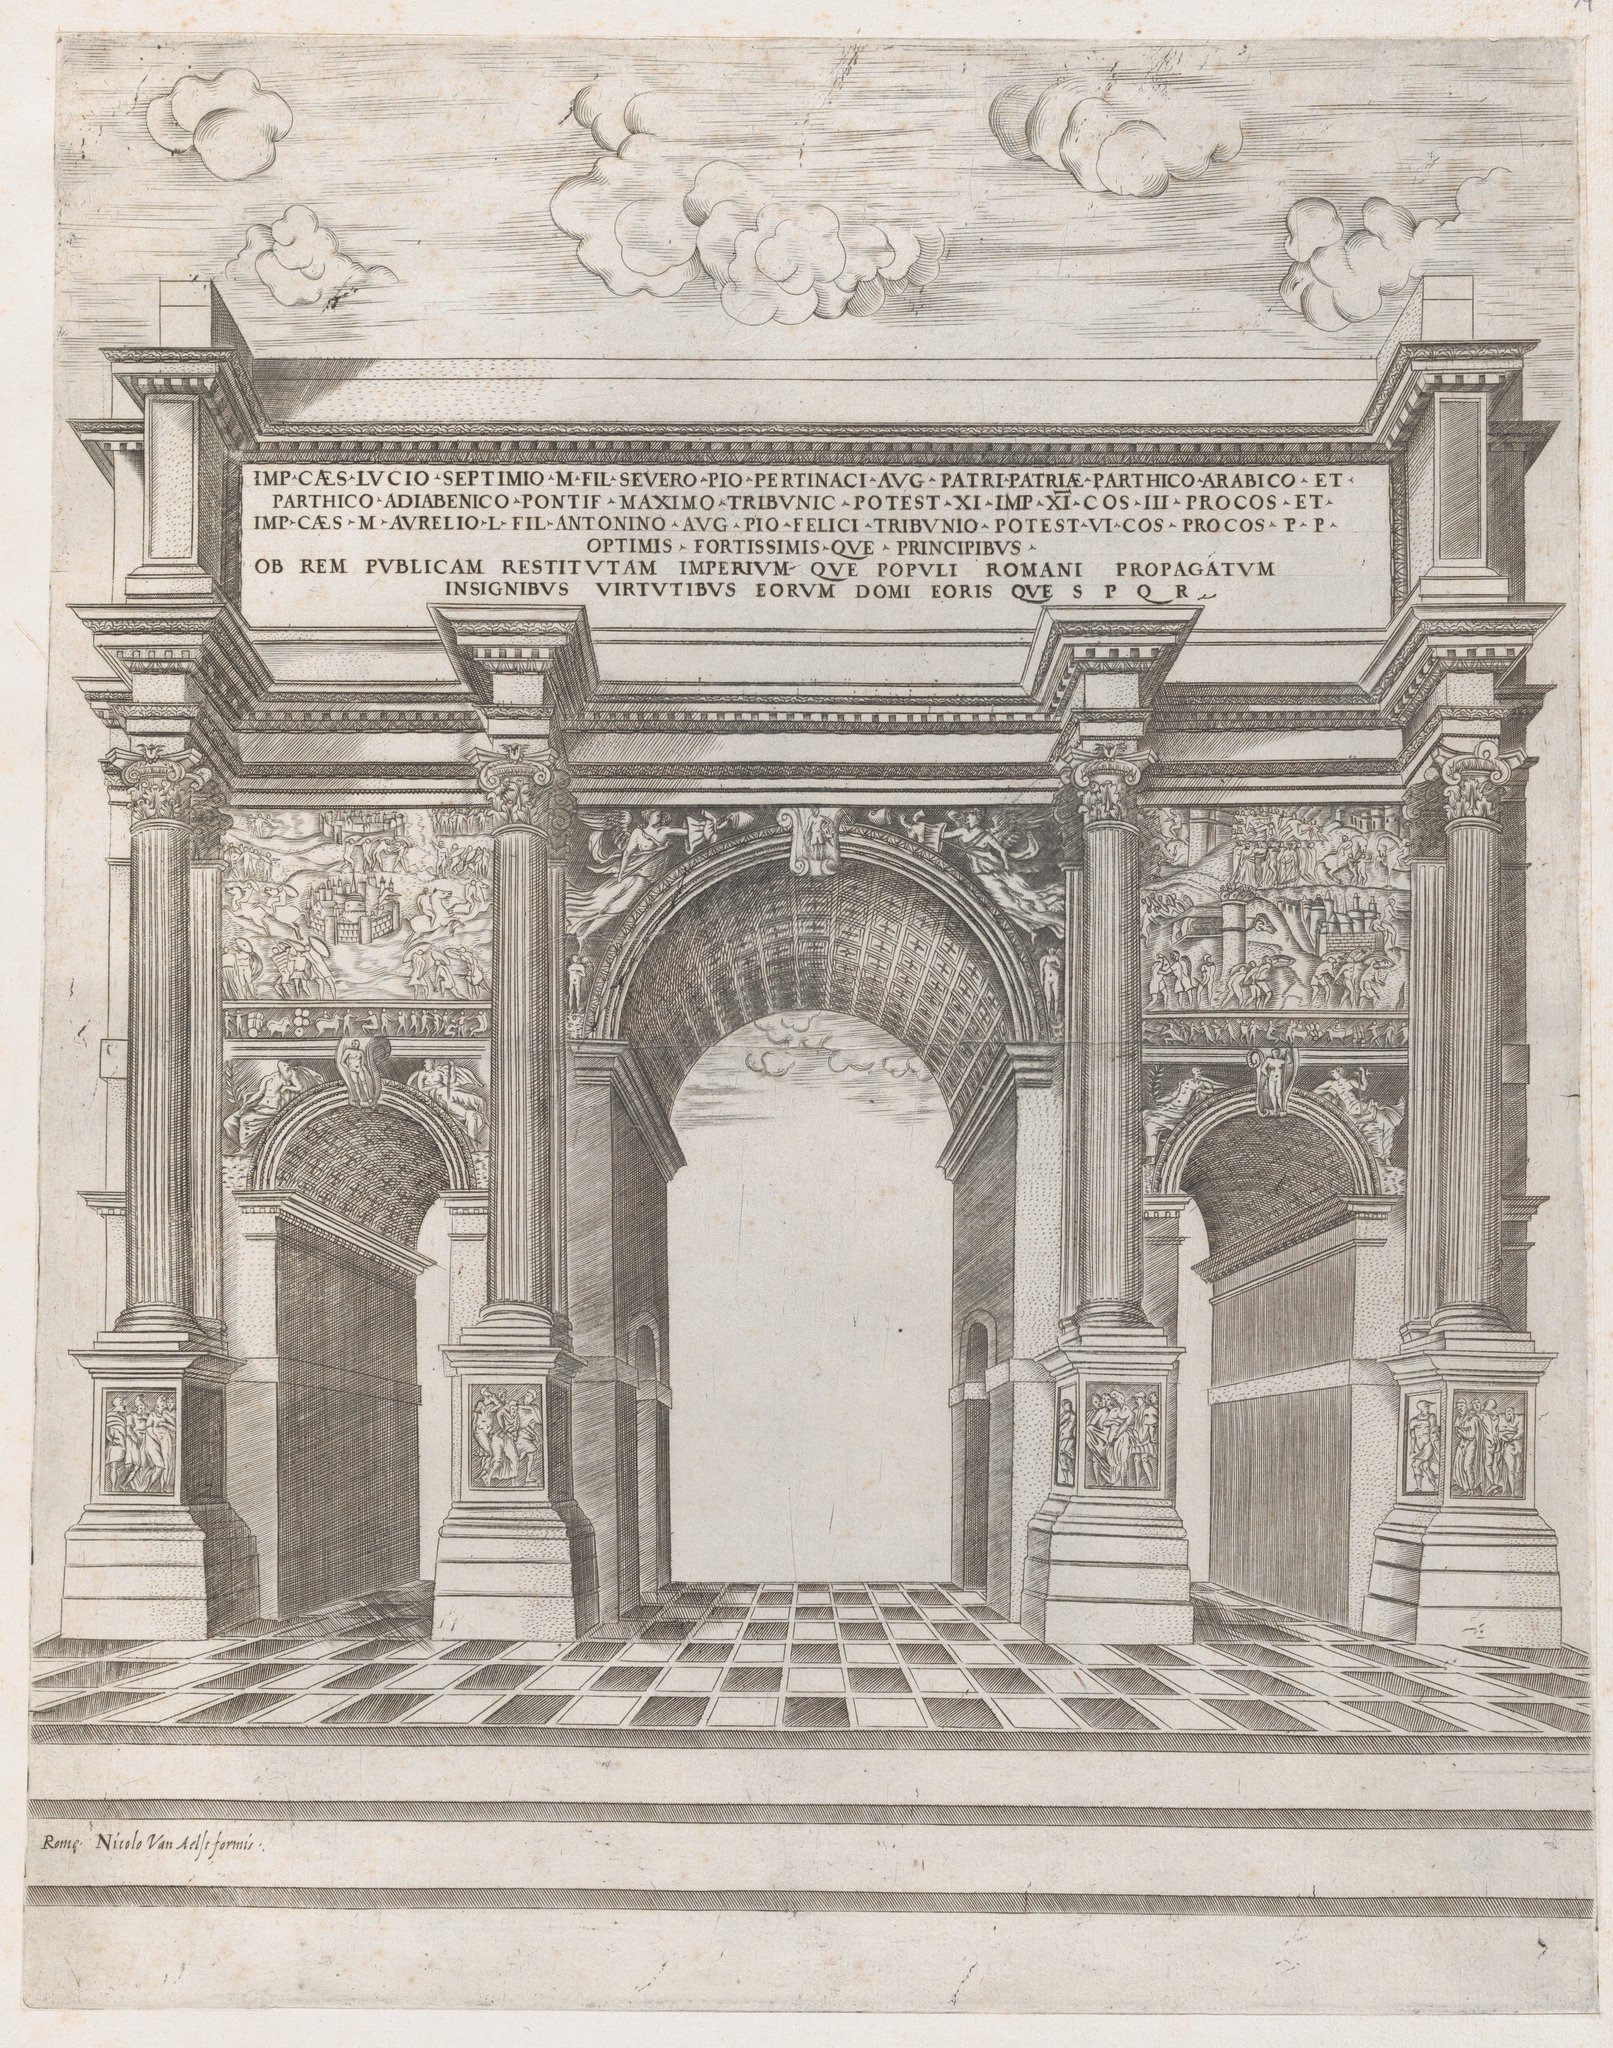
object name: print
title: Arch of Septimus Severus, from "Speculum Romanae Magnificentiae"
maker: Anonymous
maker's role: artist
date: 1501-1600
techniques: engraving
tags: architecture,arches,rome